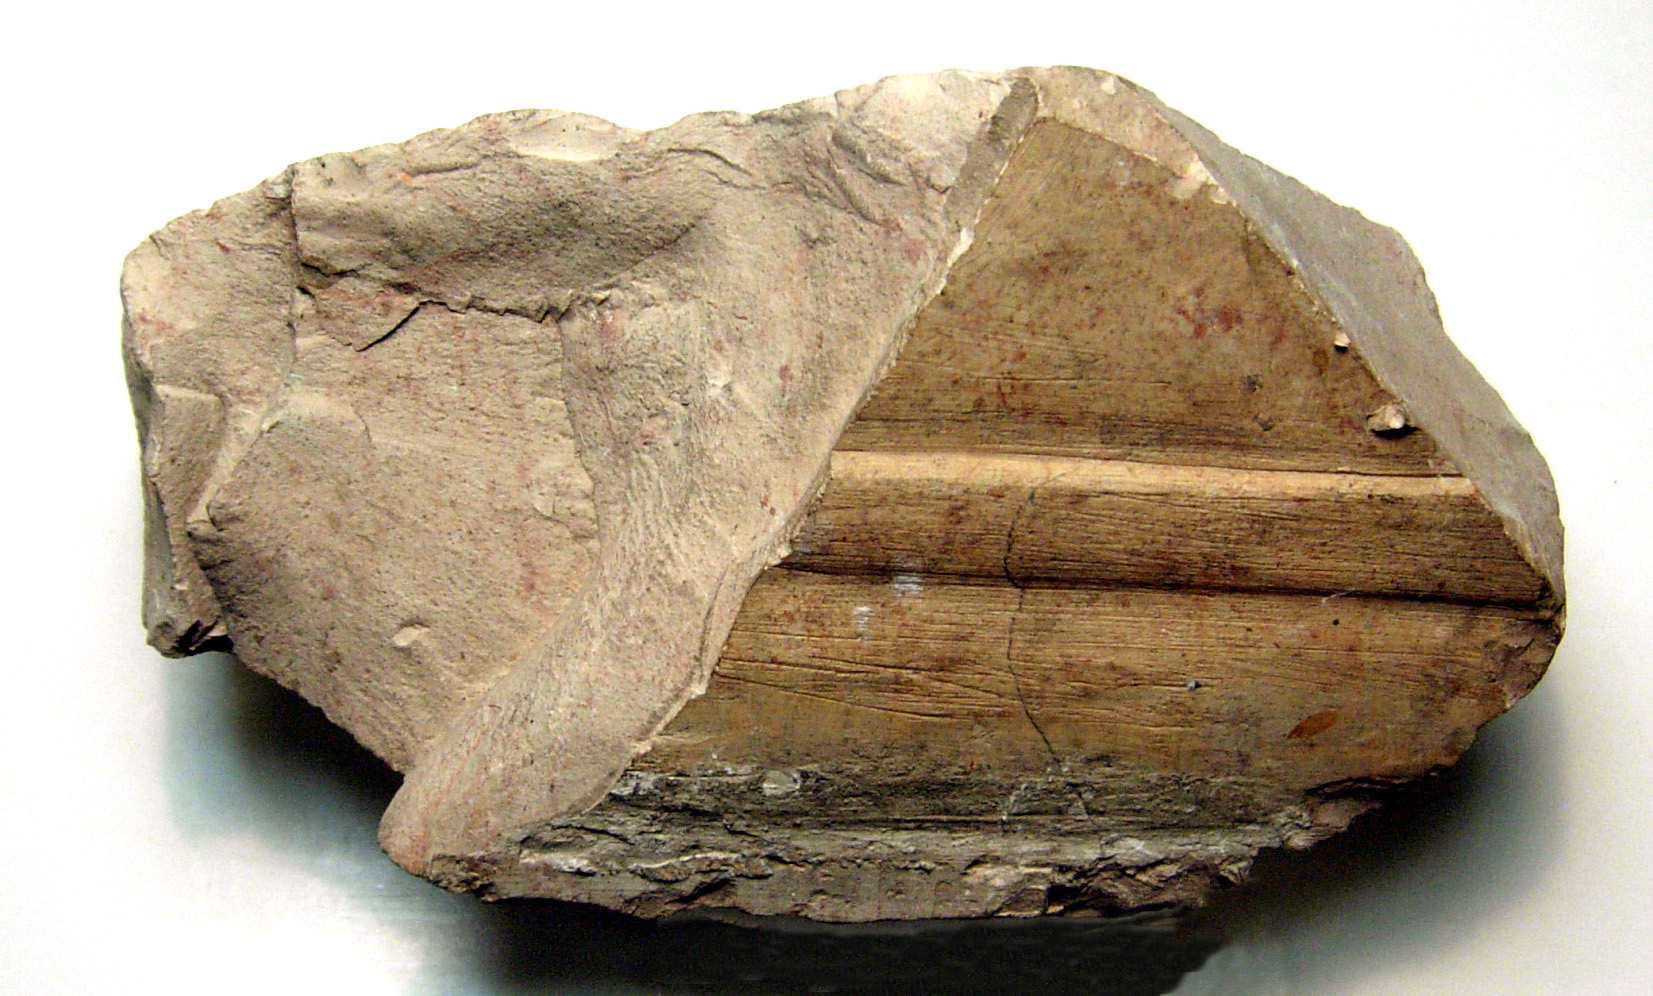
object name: relief, tomb of nespekashuty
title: Raised Relief Fragment with Column Line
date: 664-610 BCE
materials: limestone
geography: egypt